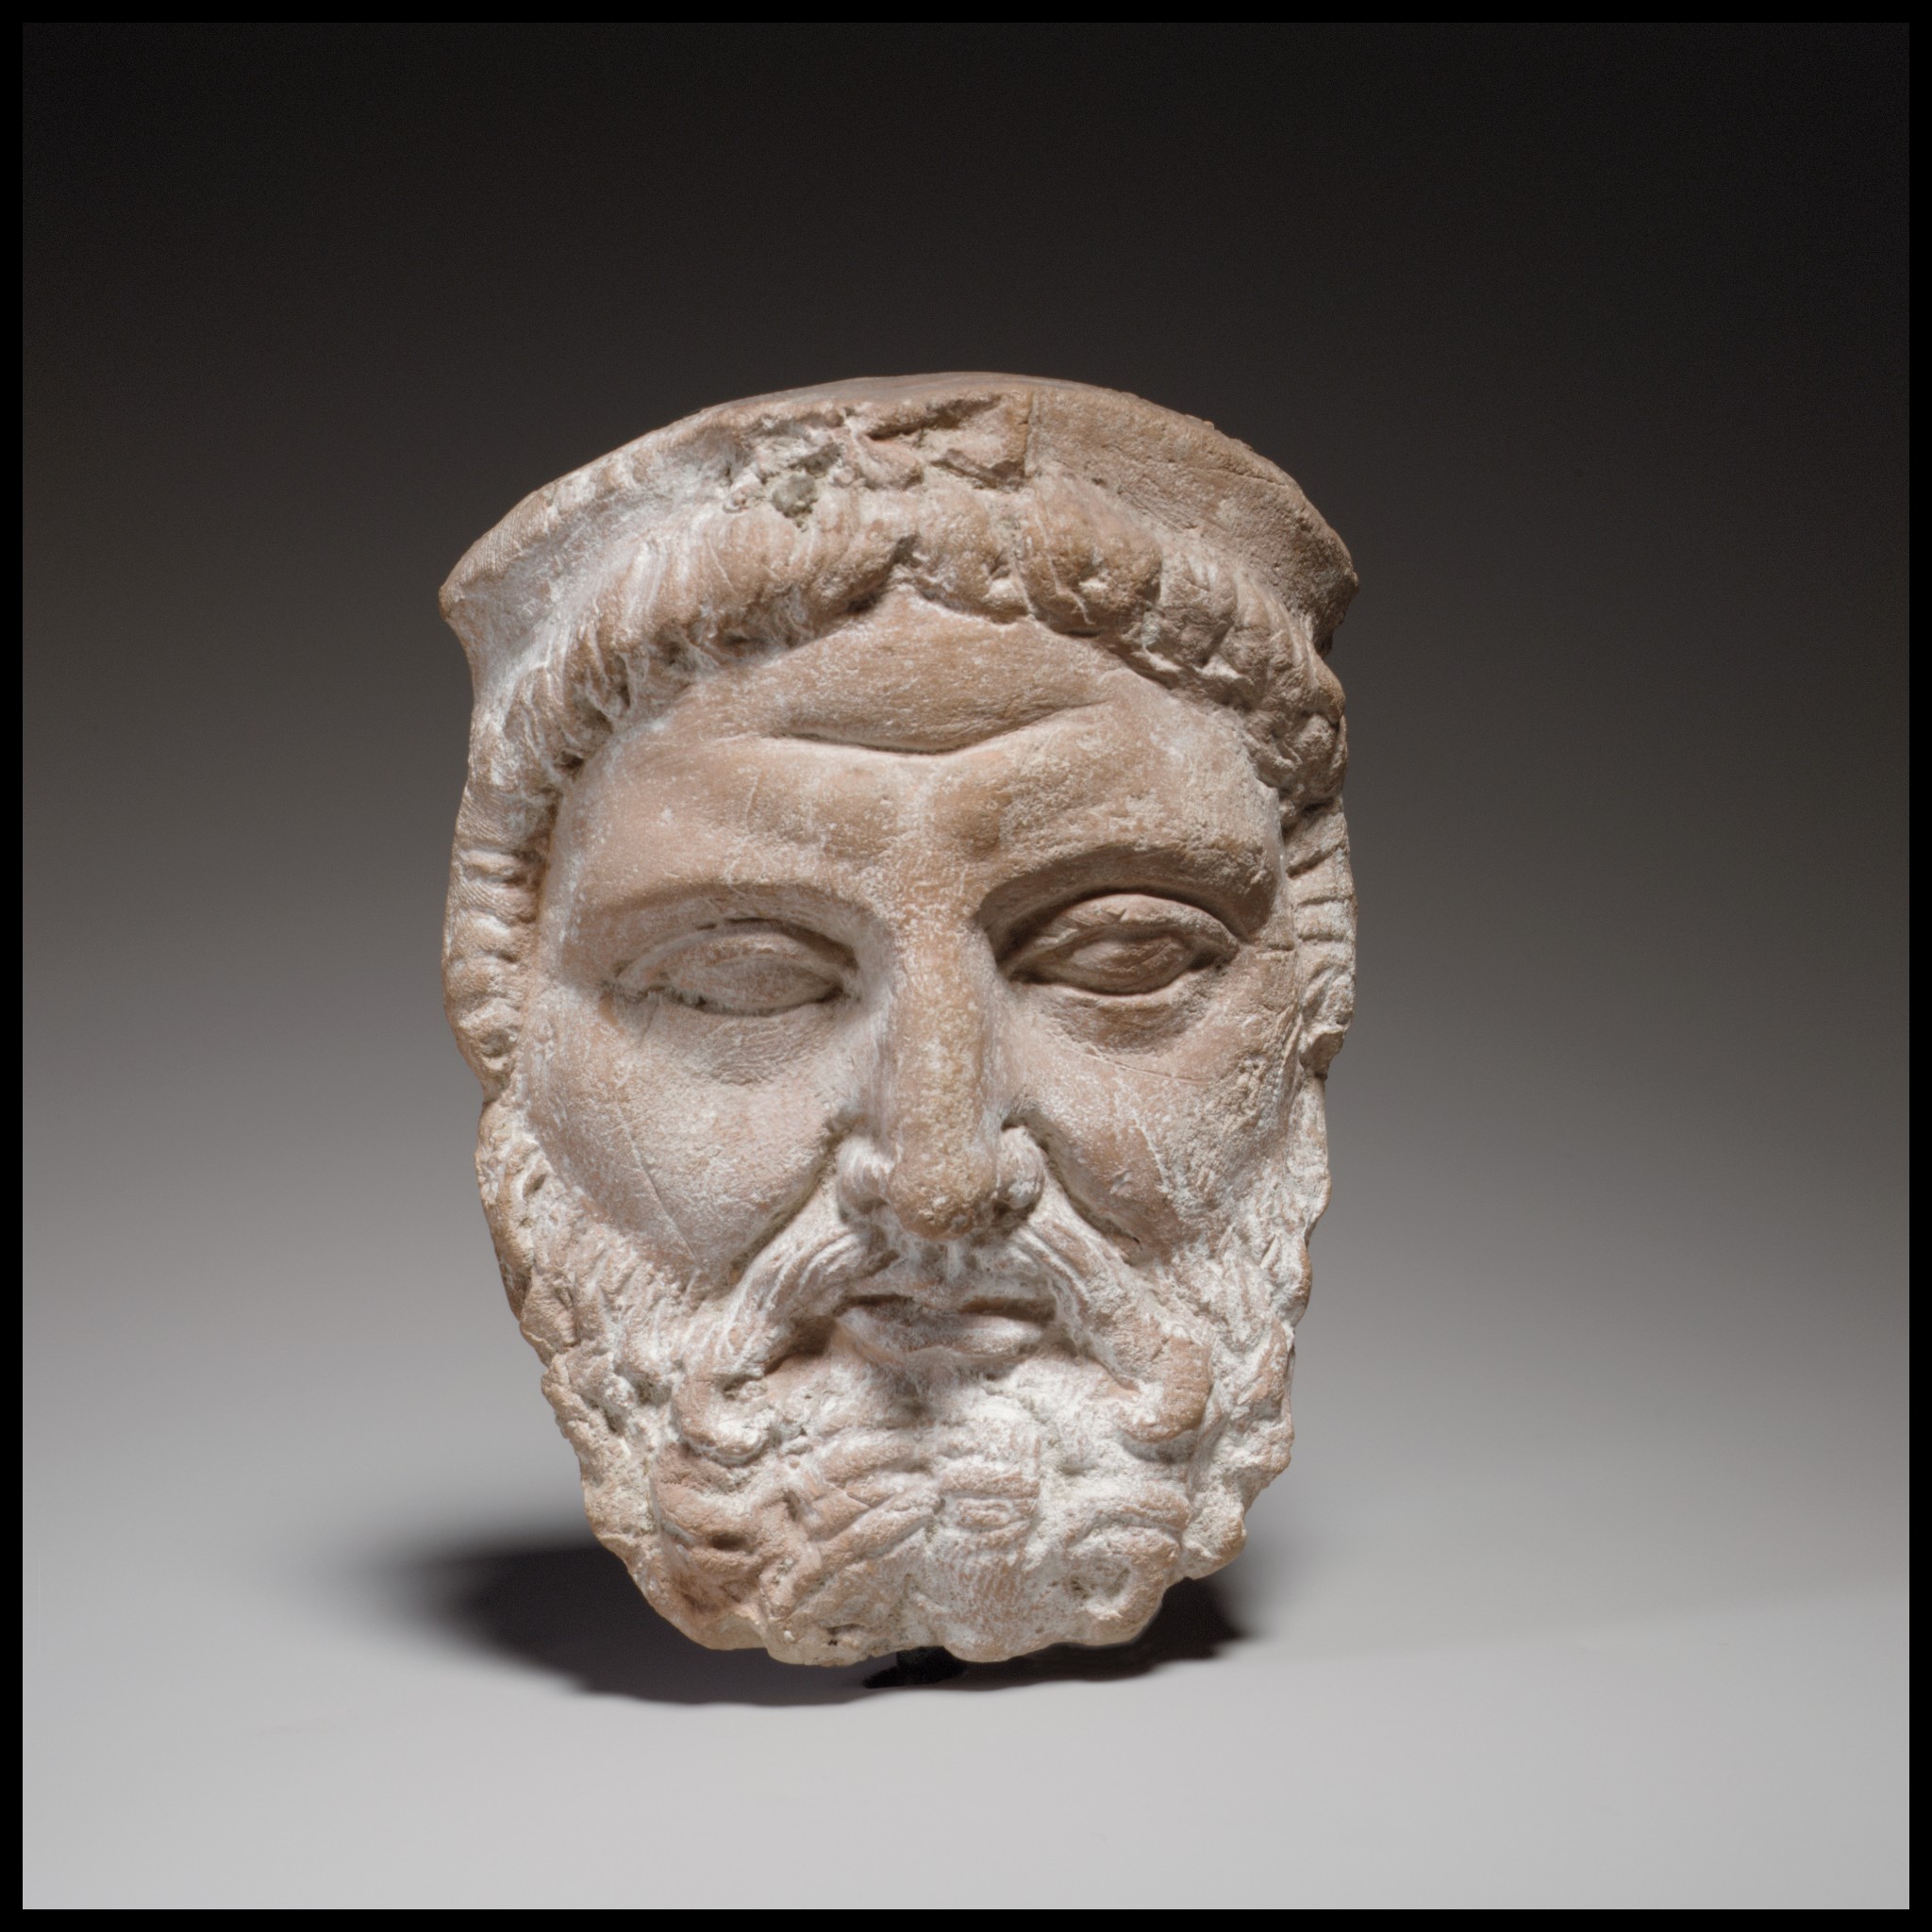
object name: mask of dionysos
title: Dionysos mask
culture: cypriot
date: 200-101 BCE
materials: terracotta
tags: masks,dionysus